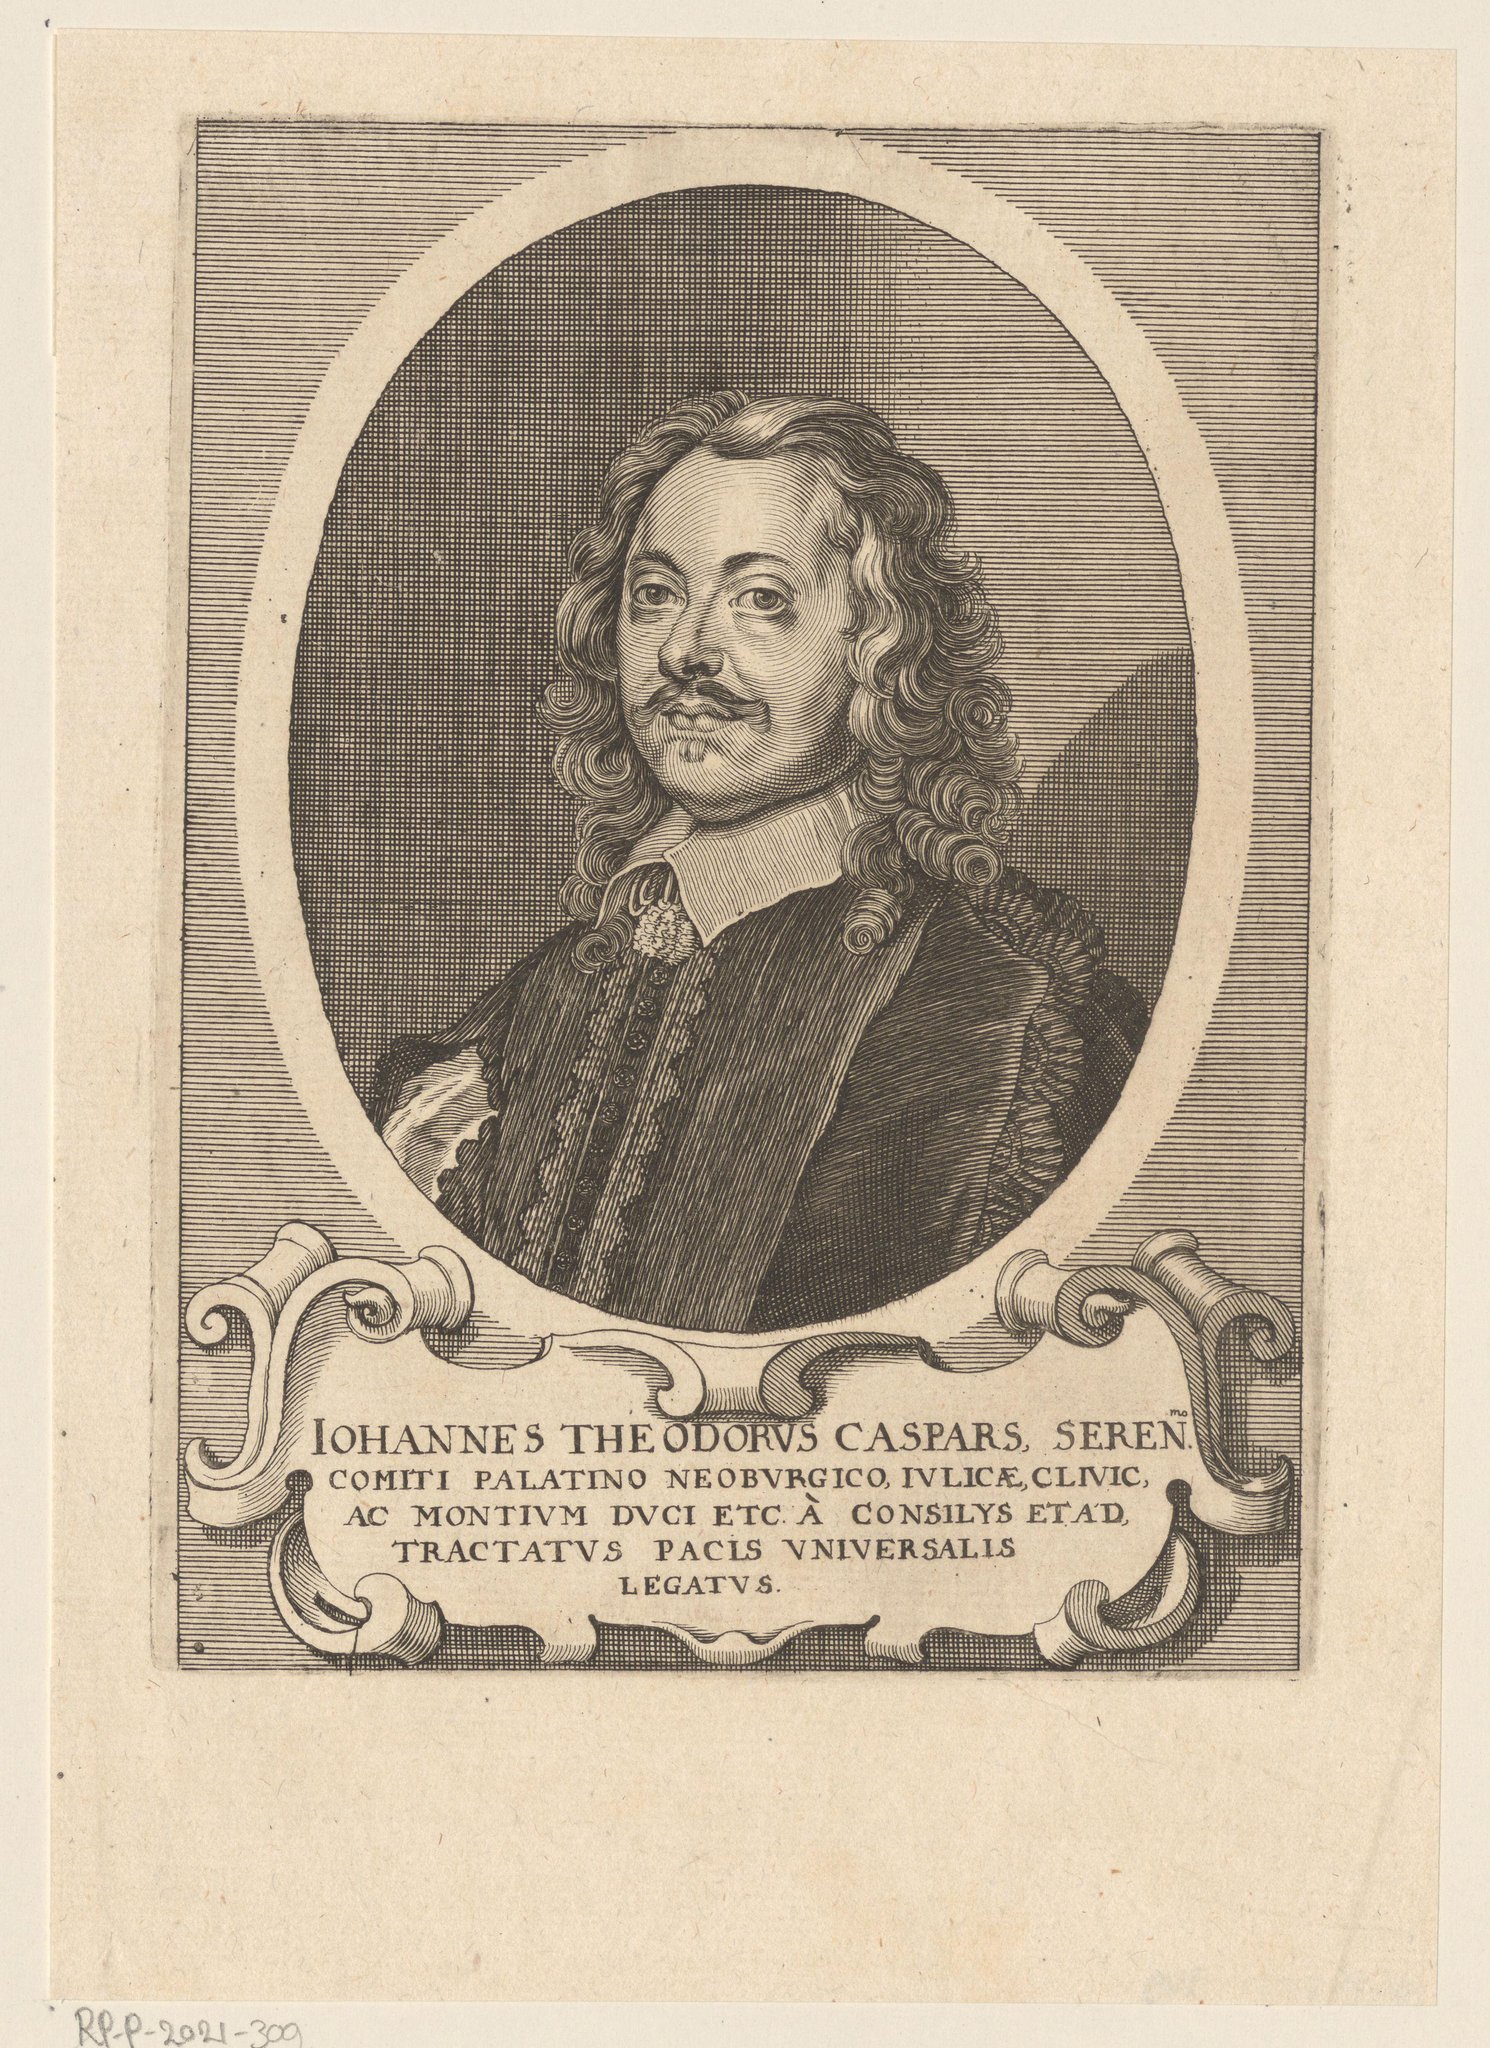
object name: print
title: Portret van Johann Theodor Caspars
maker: Anonymous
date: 1652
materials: paper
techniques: engraving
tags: historical persons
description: Prent mogelijk uit: Theatrum Europaeum. Frankfurt am Main: erven Matthäus Merian I, 1652, dl. 6.